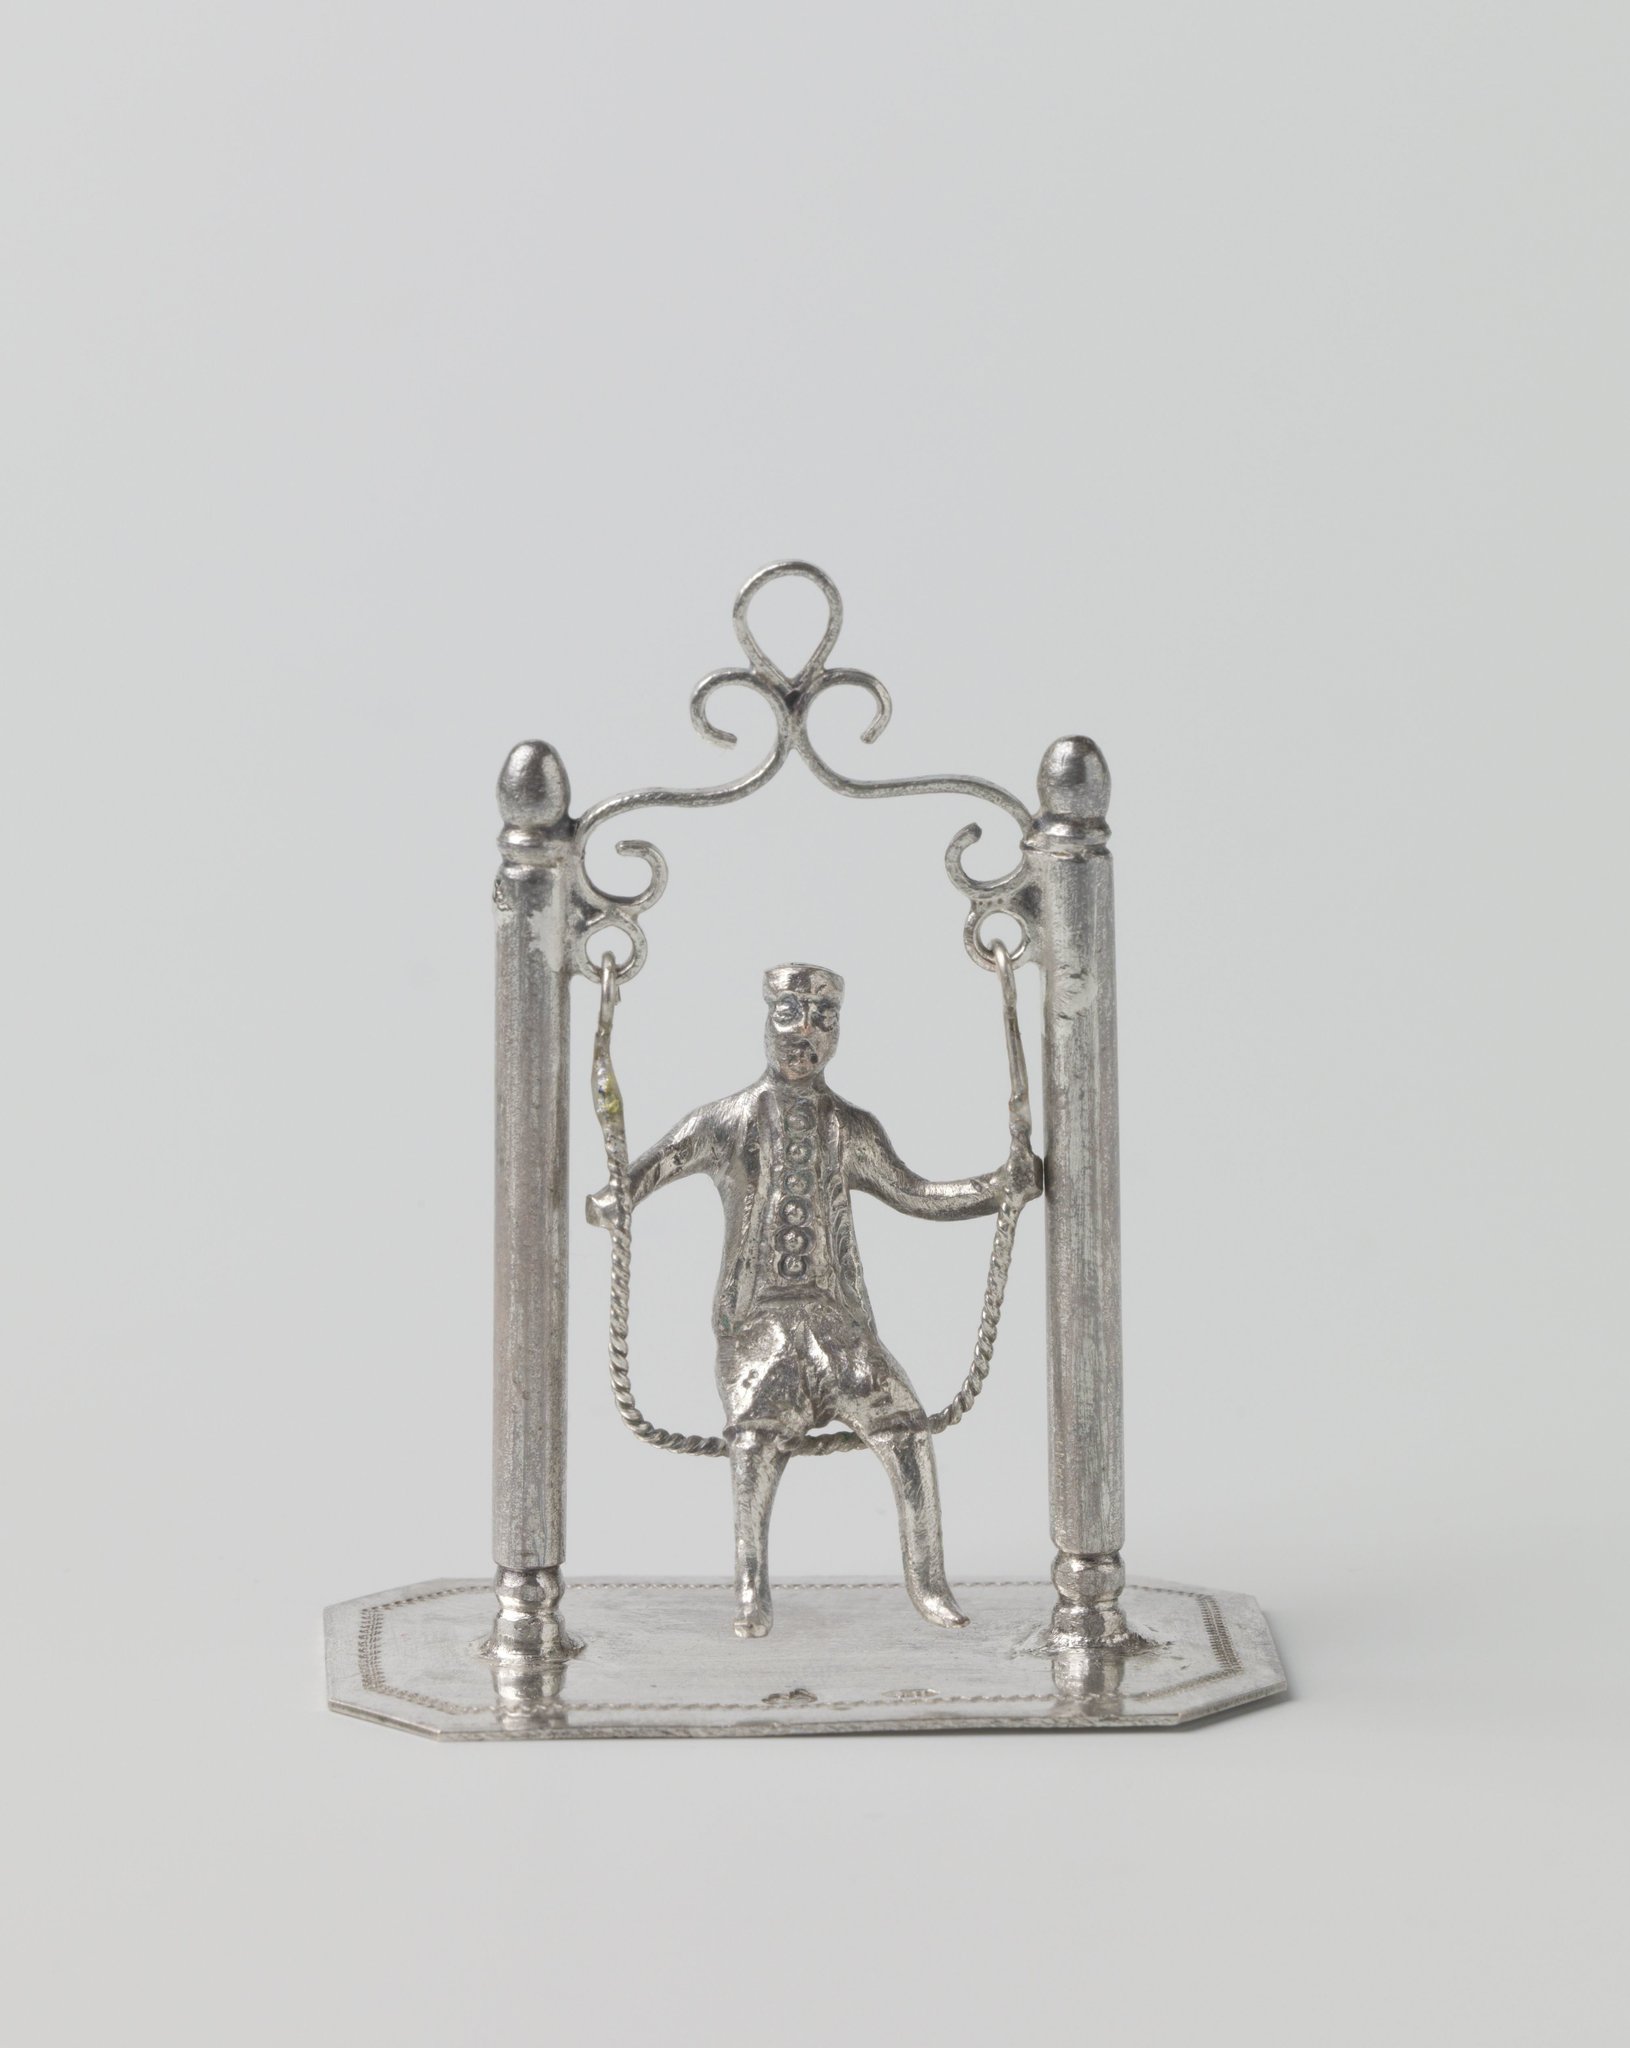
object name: miniature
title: Kind op schommel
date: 1822-1827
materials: silver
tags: swing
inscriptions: maker's mark: ‘B+’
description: Op een langwerpige plaat staat een schommel waarop een man zit. Langs de rand van de plaat is een zig-zag lijn gegraveerd. Het beeld is gemerkt met een dolfijn en een meesterteken.